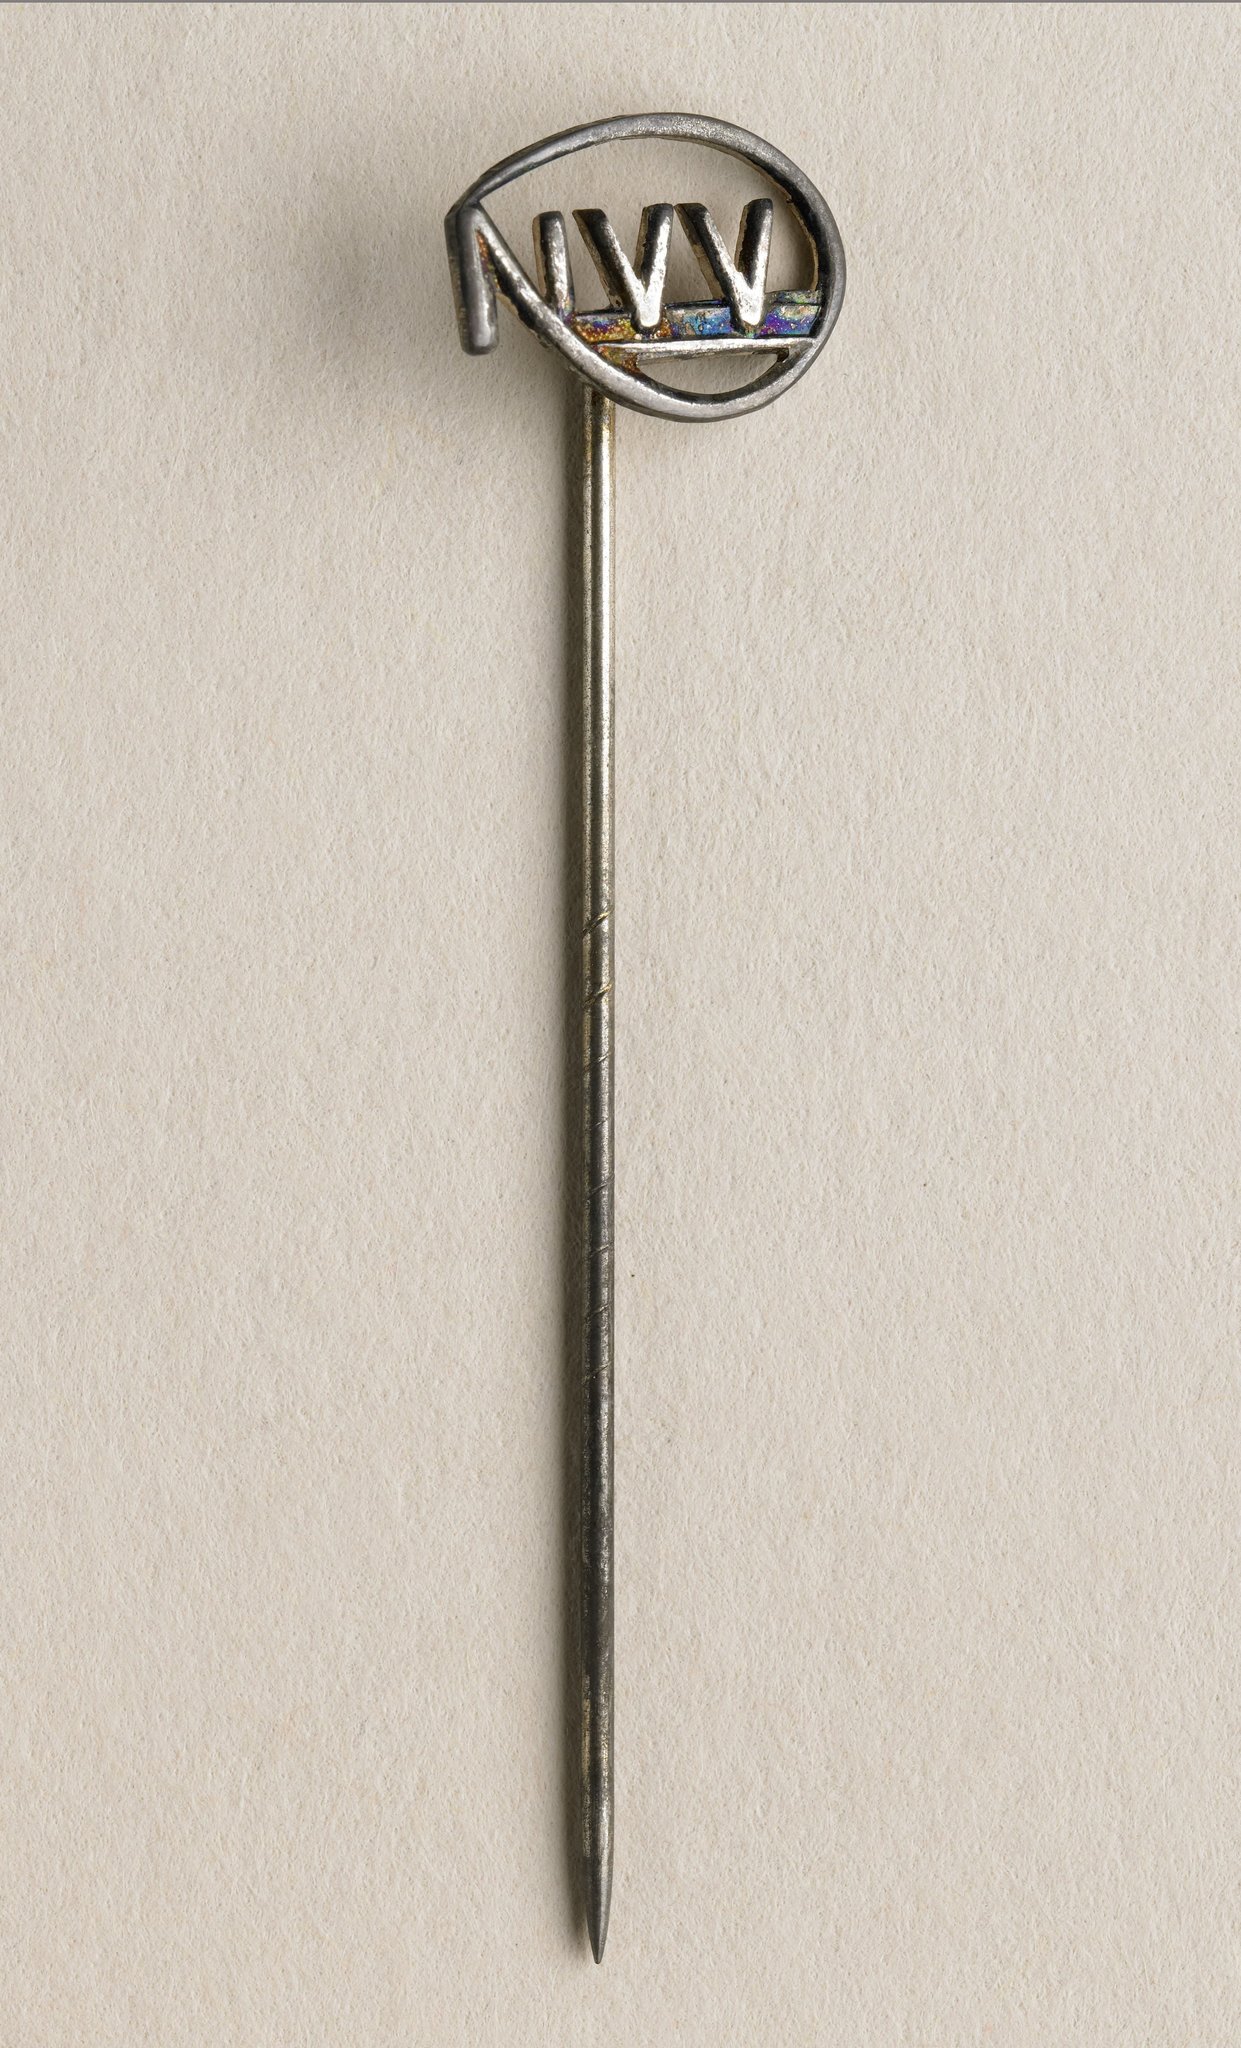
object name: pin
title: NVV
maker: Anonymous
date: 1925-1950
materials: metal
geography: netherlands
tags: amsterdam, the hague, willem drees, netherlands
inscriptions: inscription: ‘NVV’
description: Speld van de vakbond NVV met lange gladde pen.